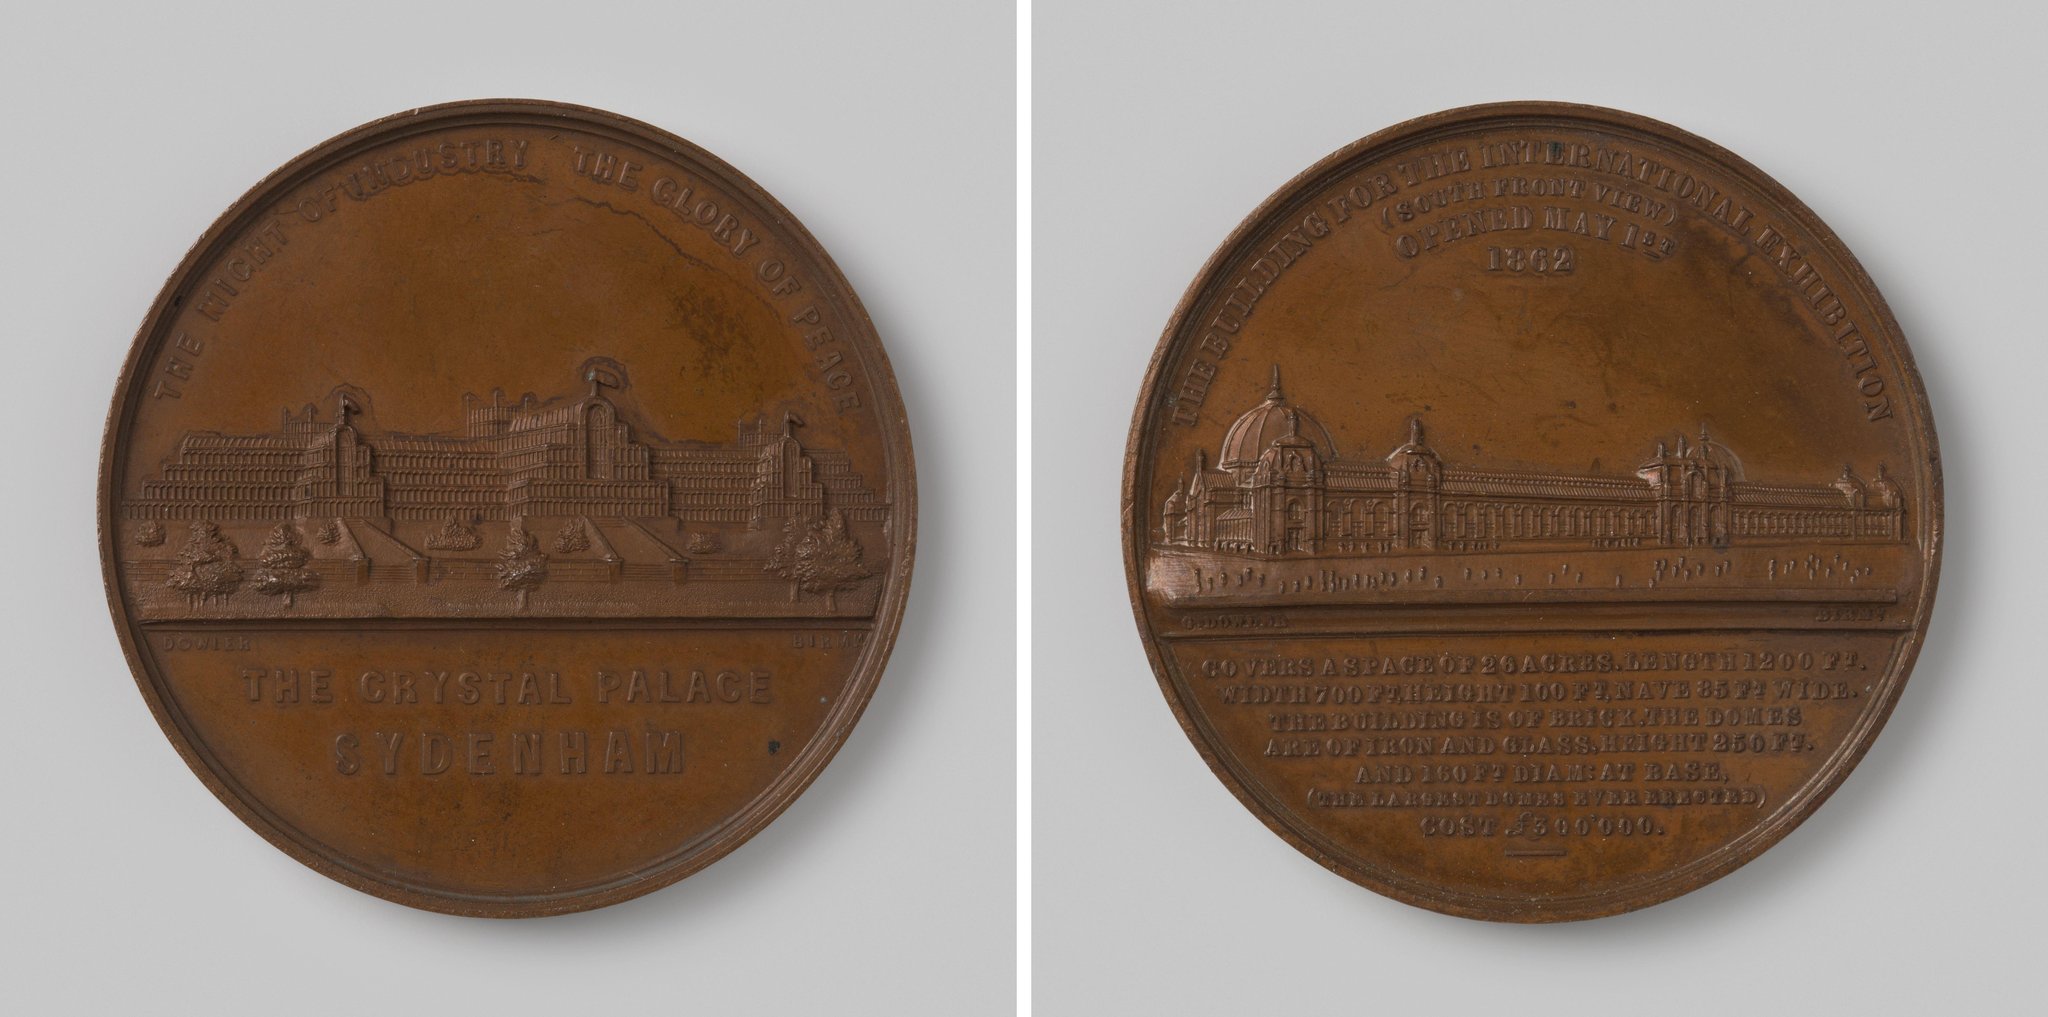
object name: history medal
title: Expositie in het Crystal Palace te Sydenham 1862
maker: george dowler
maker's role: modelleur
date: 1862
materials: bronze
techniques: striking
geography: birmingham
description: Bronzen penning, op de voorzijde het Crystal Palace met park, met bovenaan omschrift en twee regels afsnedetekst, op de keerzijde vier regels omschrift, het tentoonstellingsgebouw en zeven regels afsnedetekst